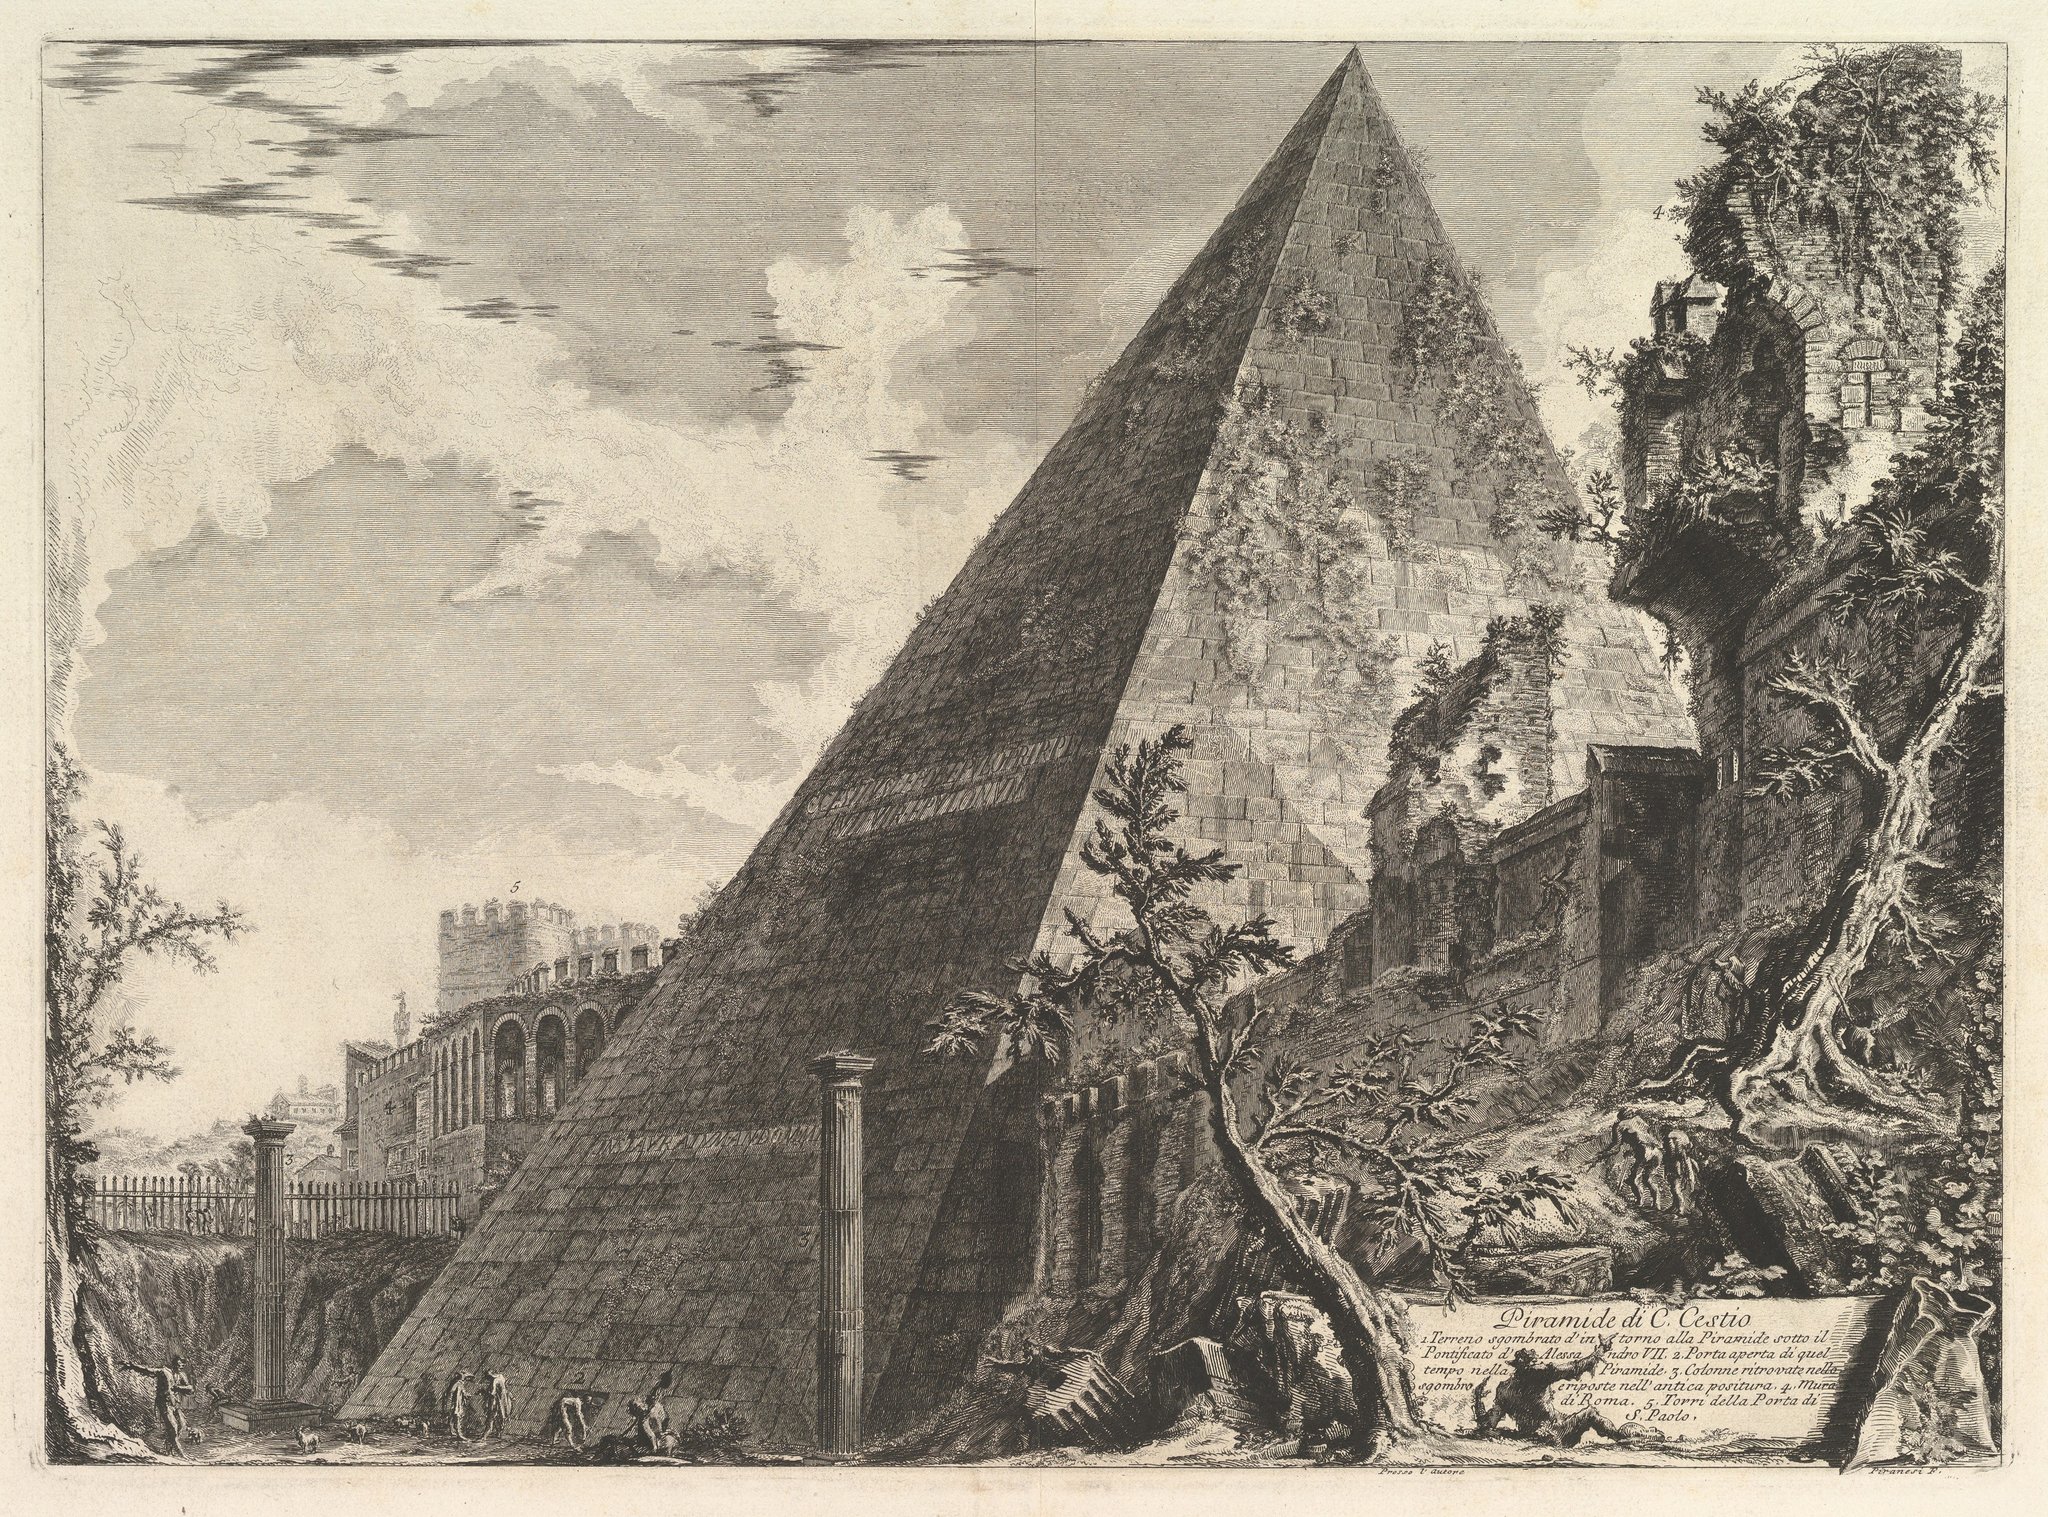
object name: print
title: The Pyramid of Gaius Cestius, from Vedute di Roma (Roman Views)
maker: giovanni battista piranesi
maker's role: artist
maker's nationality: italian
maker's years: 1720-1778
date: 1756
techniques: etching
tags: architecture,ruins,rome